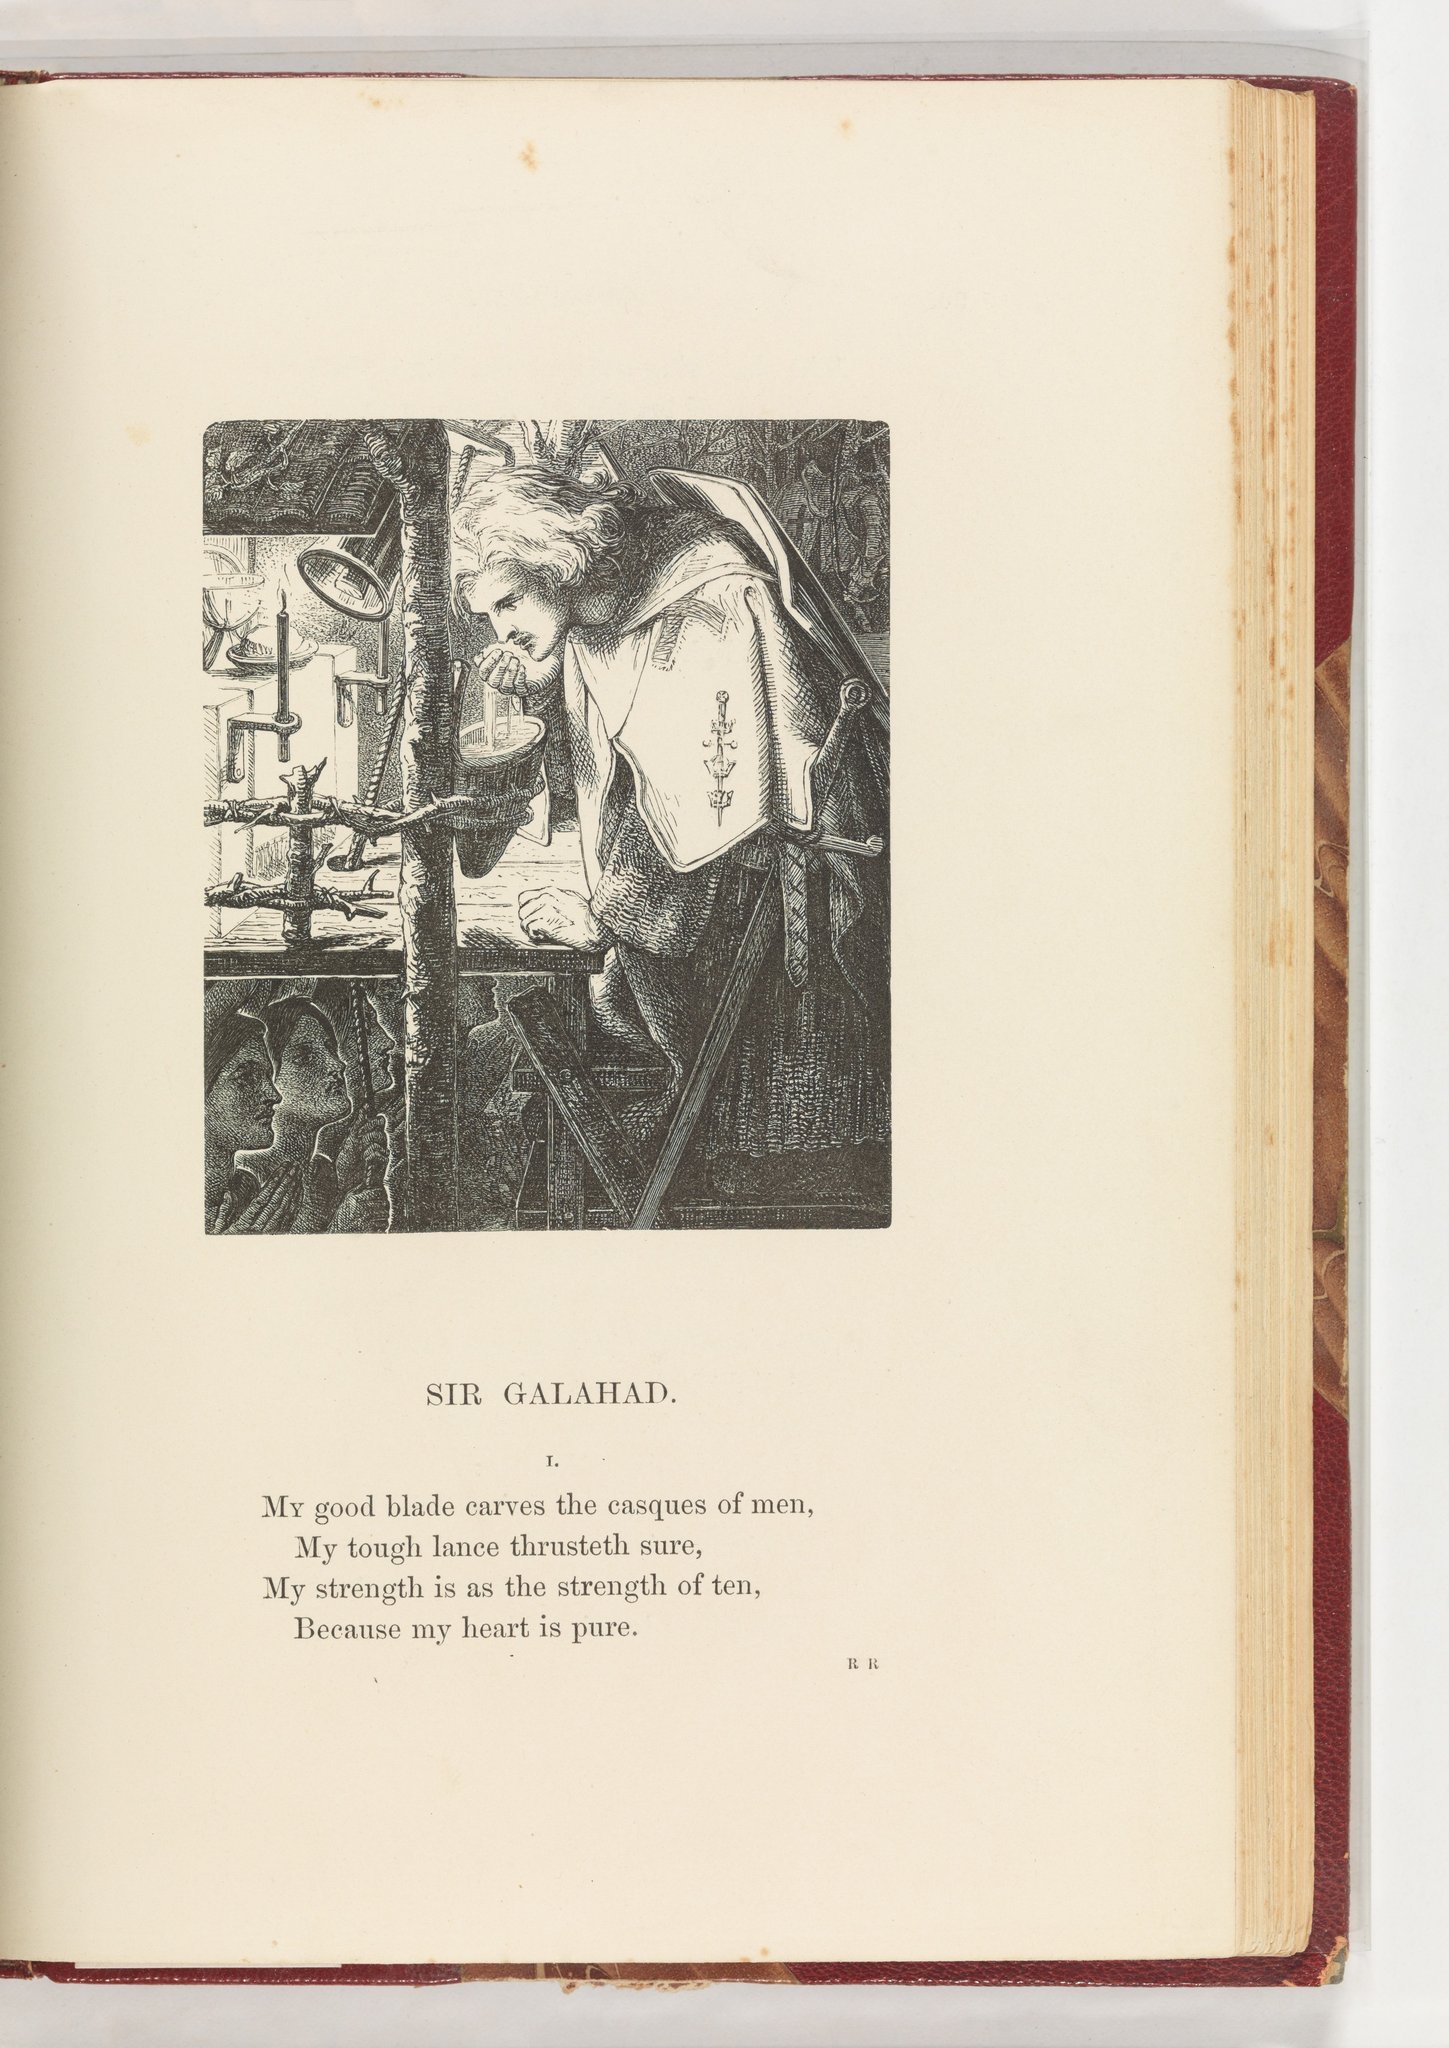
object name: book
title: Poems by Alfred Tennyson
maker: alfred tennyson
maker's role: author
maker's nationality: british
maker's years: 1809-1892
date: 1857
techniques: mezzotint, engraving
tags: poetry,men